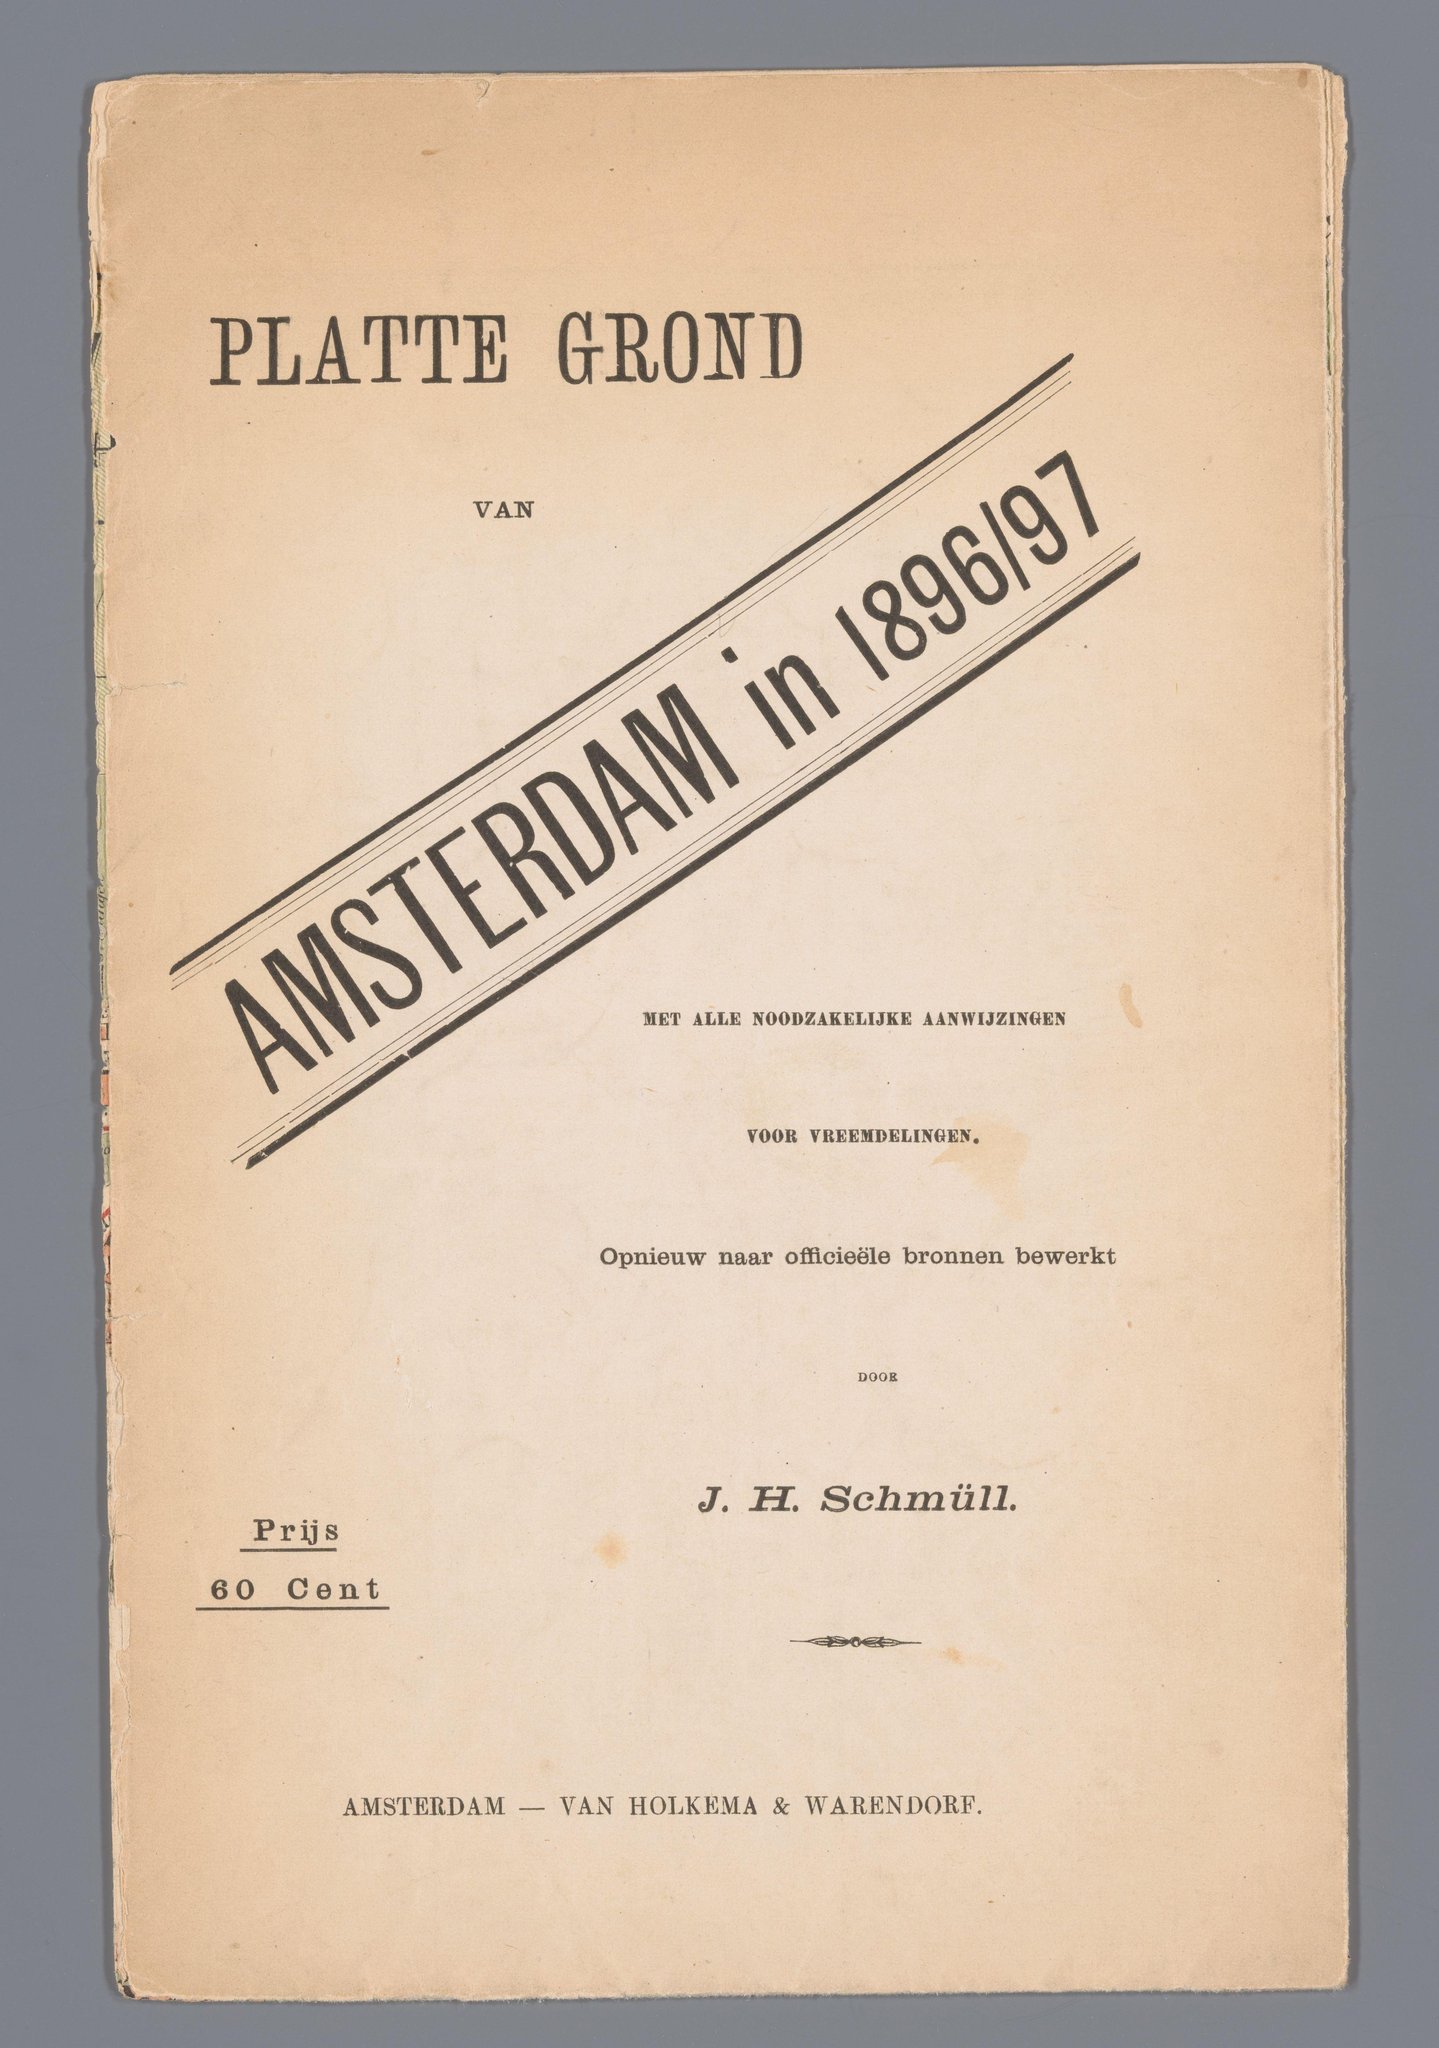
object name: area plan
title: Plattegrond van Amsterdam, opnieuw naar officiëele bronnen bewerkt door J.H. Schmüll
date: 1896-1897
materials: paper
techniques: lithograph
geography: amsterdam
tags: maps of cities, amsterdam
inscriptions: date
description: Opgevouwen plattegrond met op de achterkant een legenda en een lijst met hotels, badhuizen, vervoersmiddelen et cetera in Amsterdam.